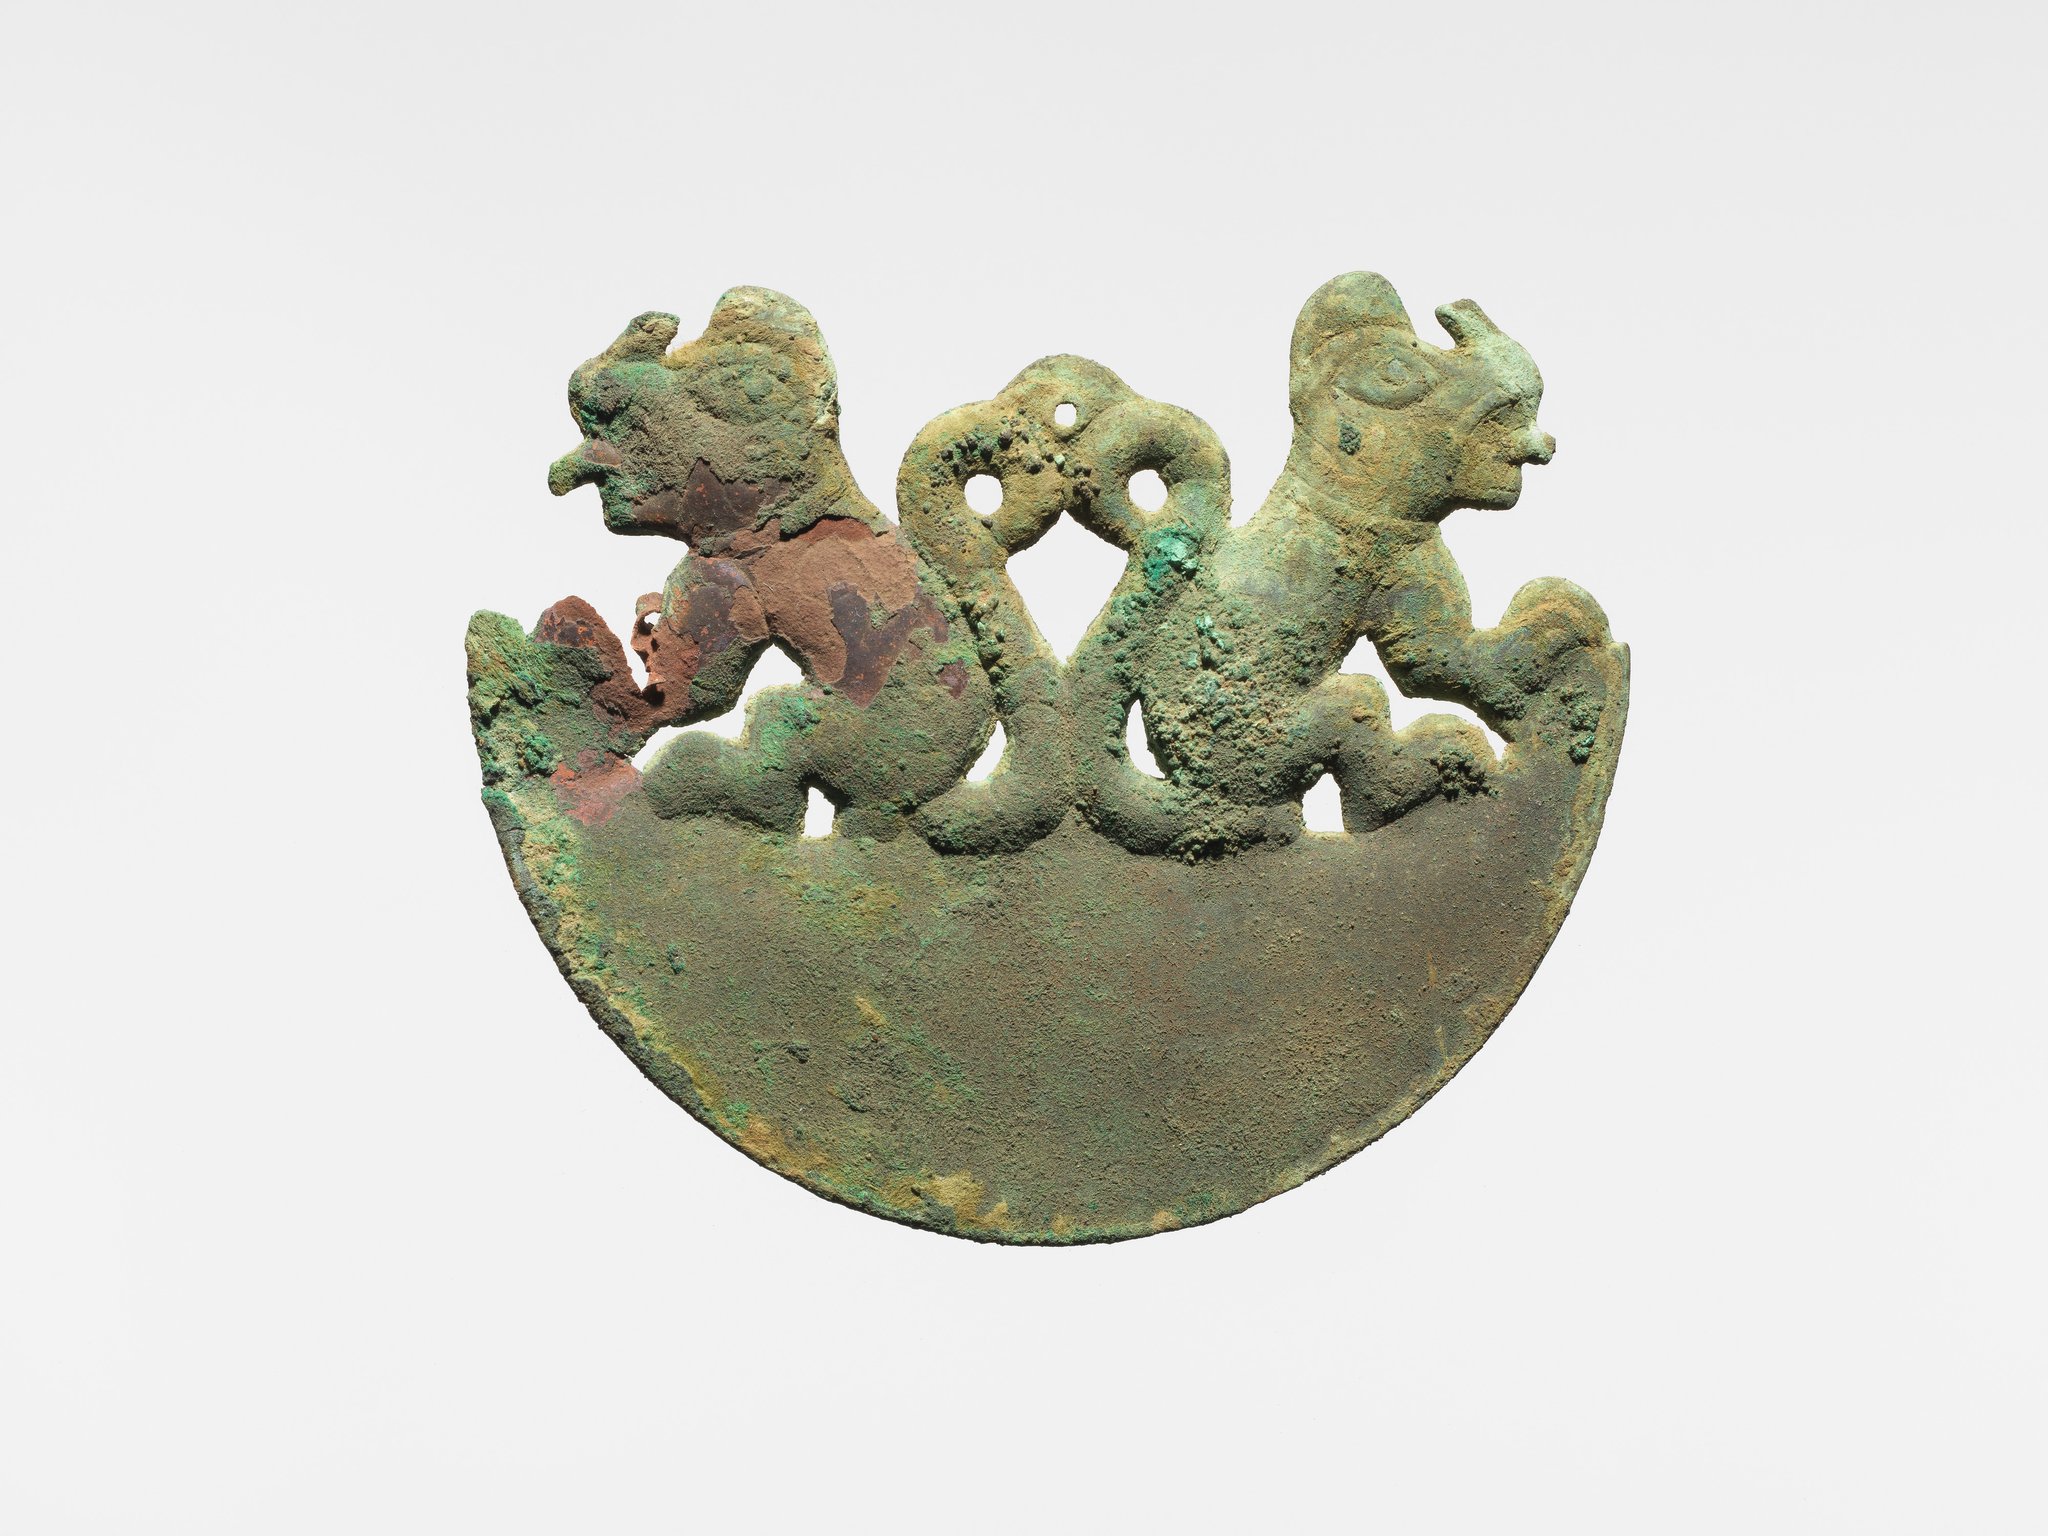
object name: ornament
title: Animal Ornament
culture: moche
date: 501-700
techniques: gilding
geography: peru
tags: animals